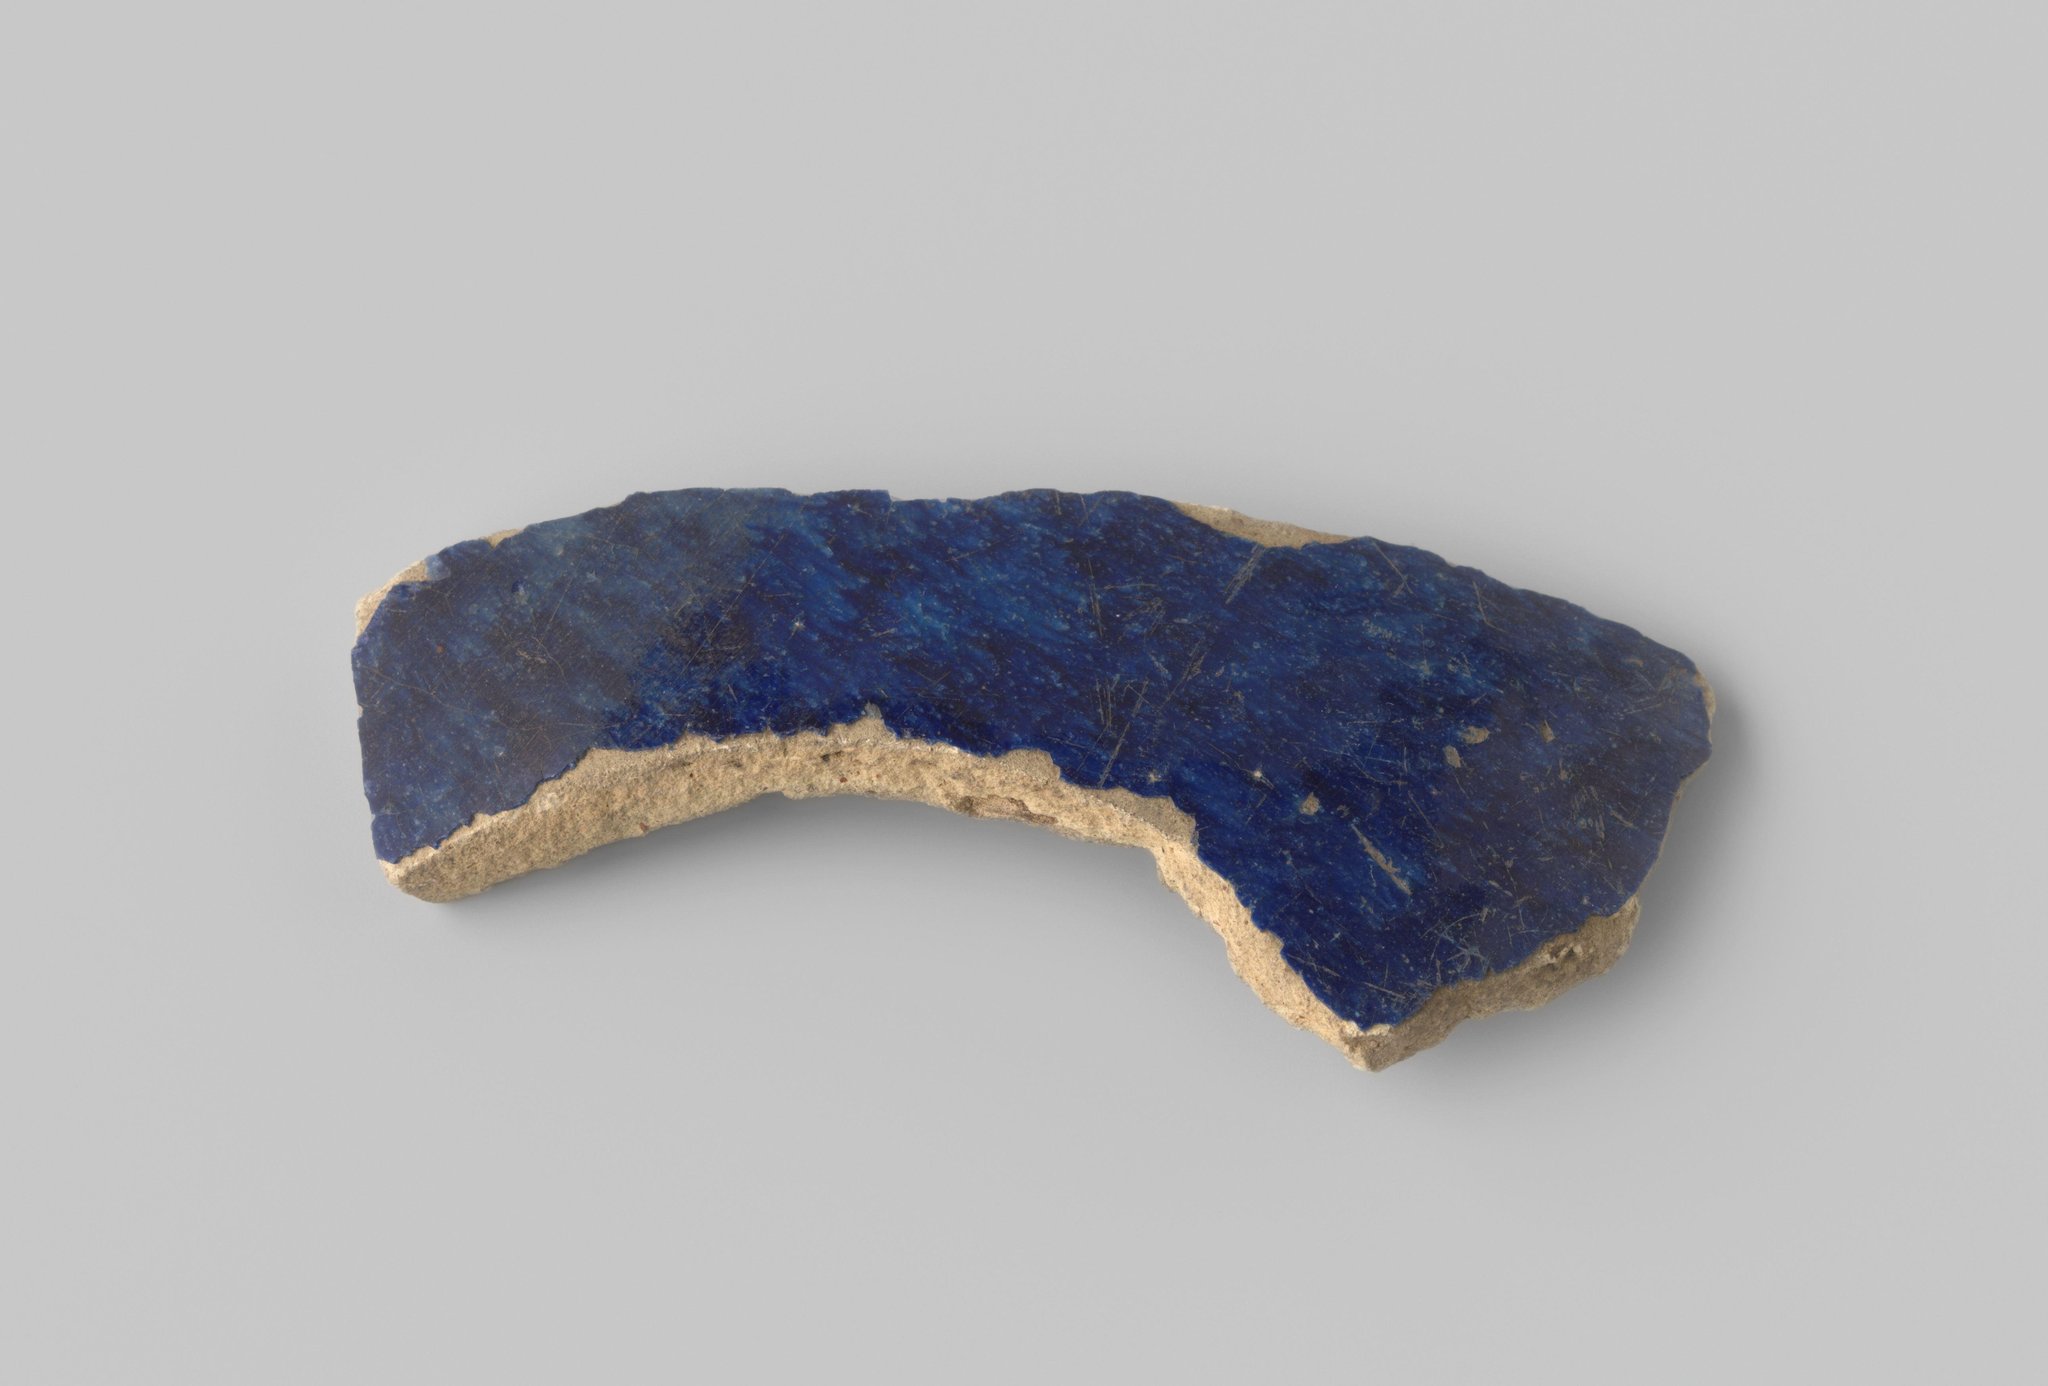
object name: sherd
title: Scherf majolica met decoratie in blauw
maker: Anonymous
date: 1500-1699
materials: earthenware, glaze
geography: northern netherlands